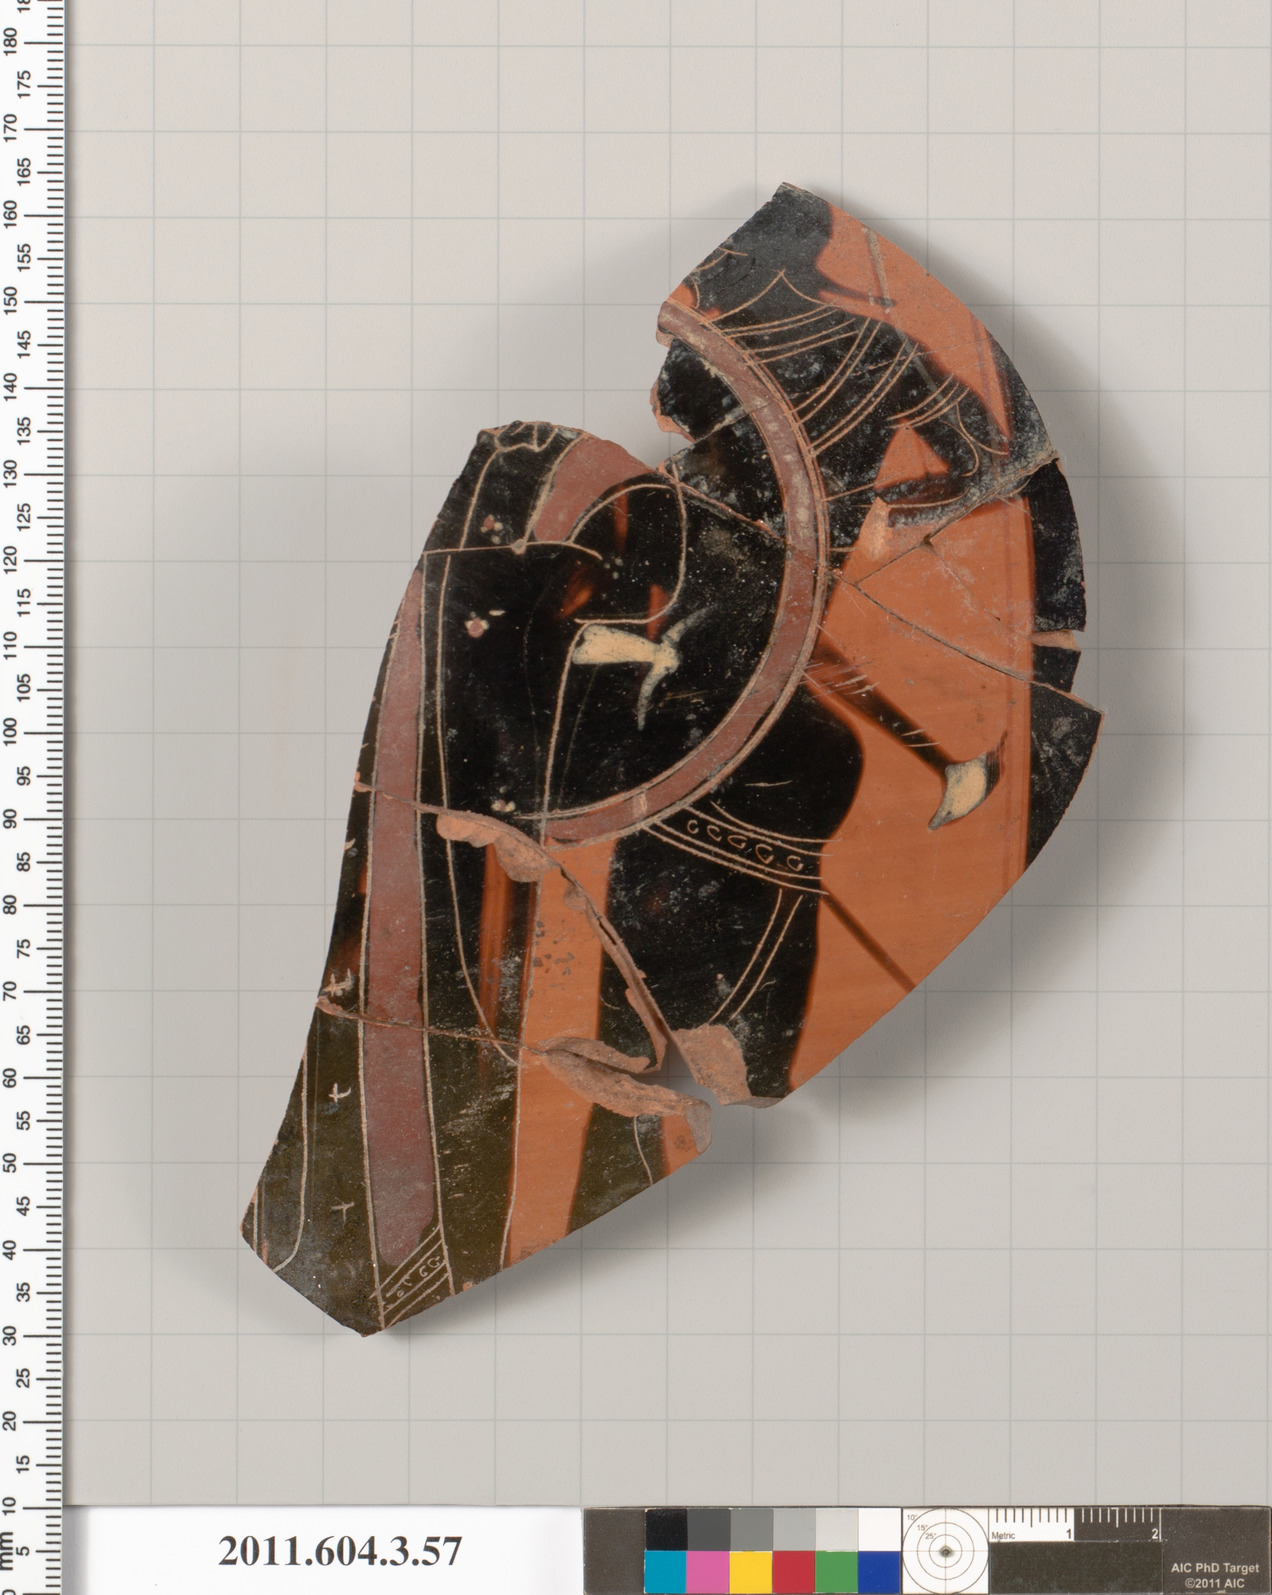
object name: amphora fragment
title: Terracotta fragment of an amphora (jar)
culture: greek, attic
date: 525-501 BCE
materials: terracotta